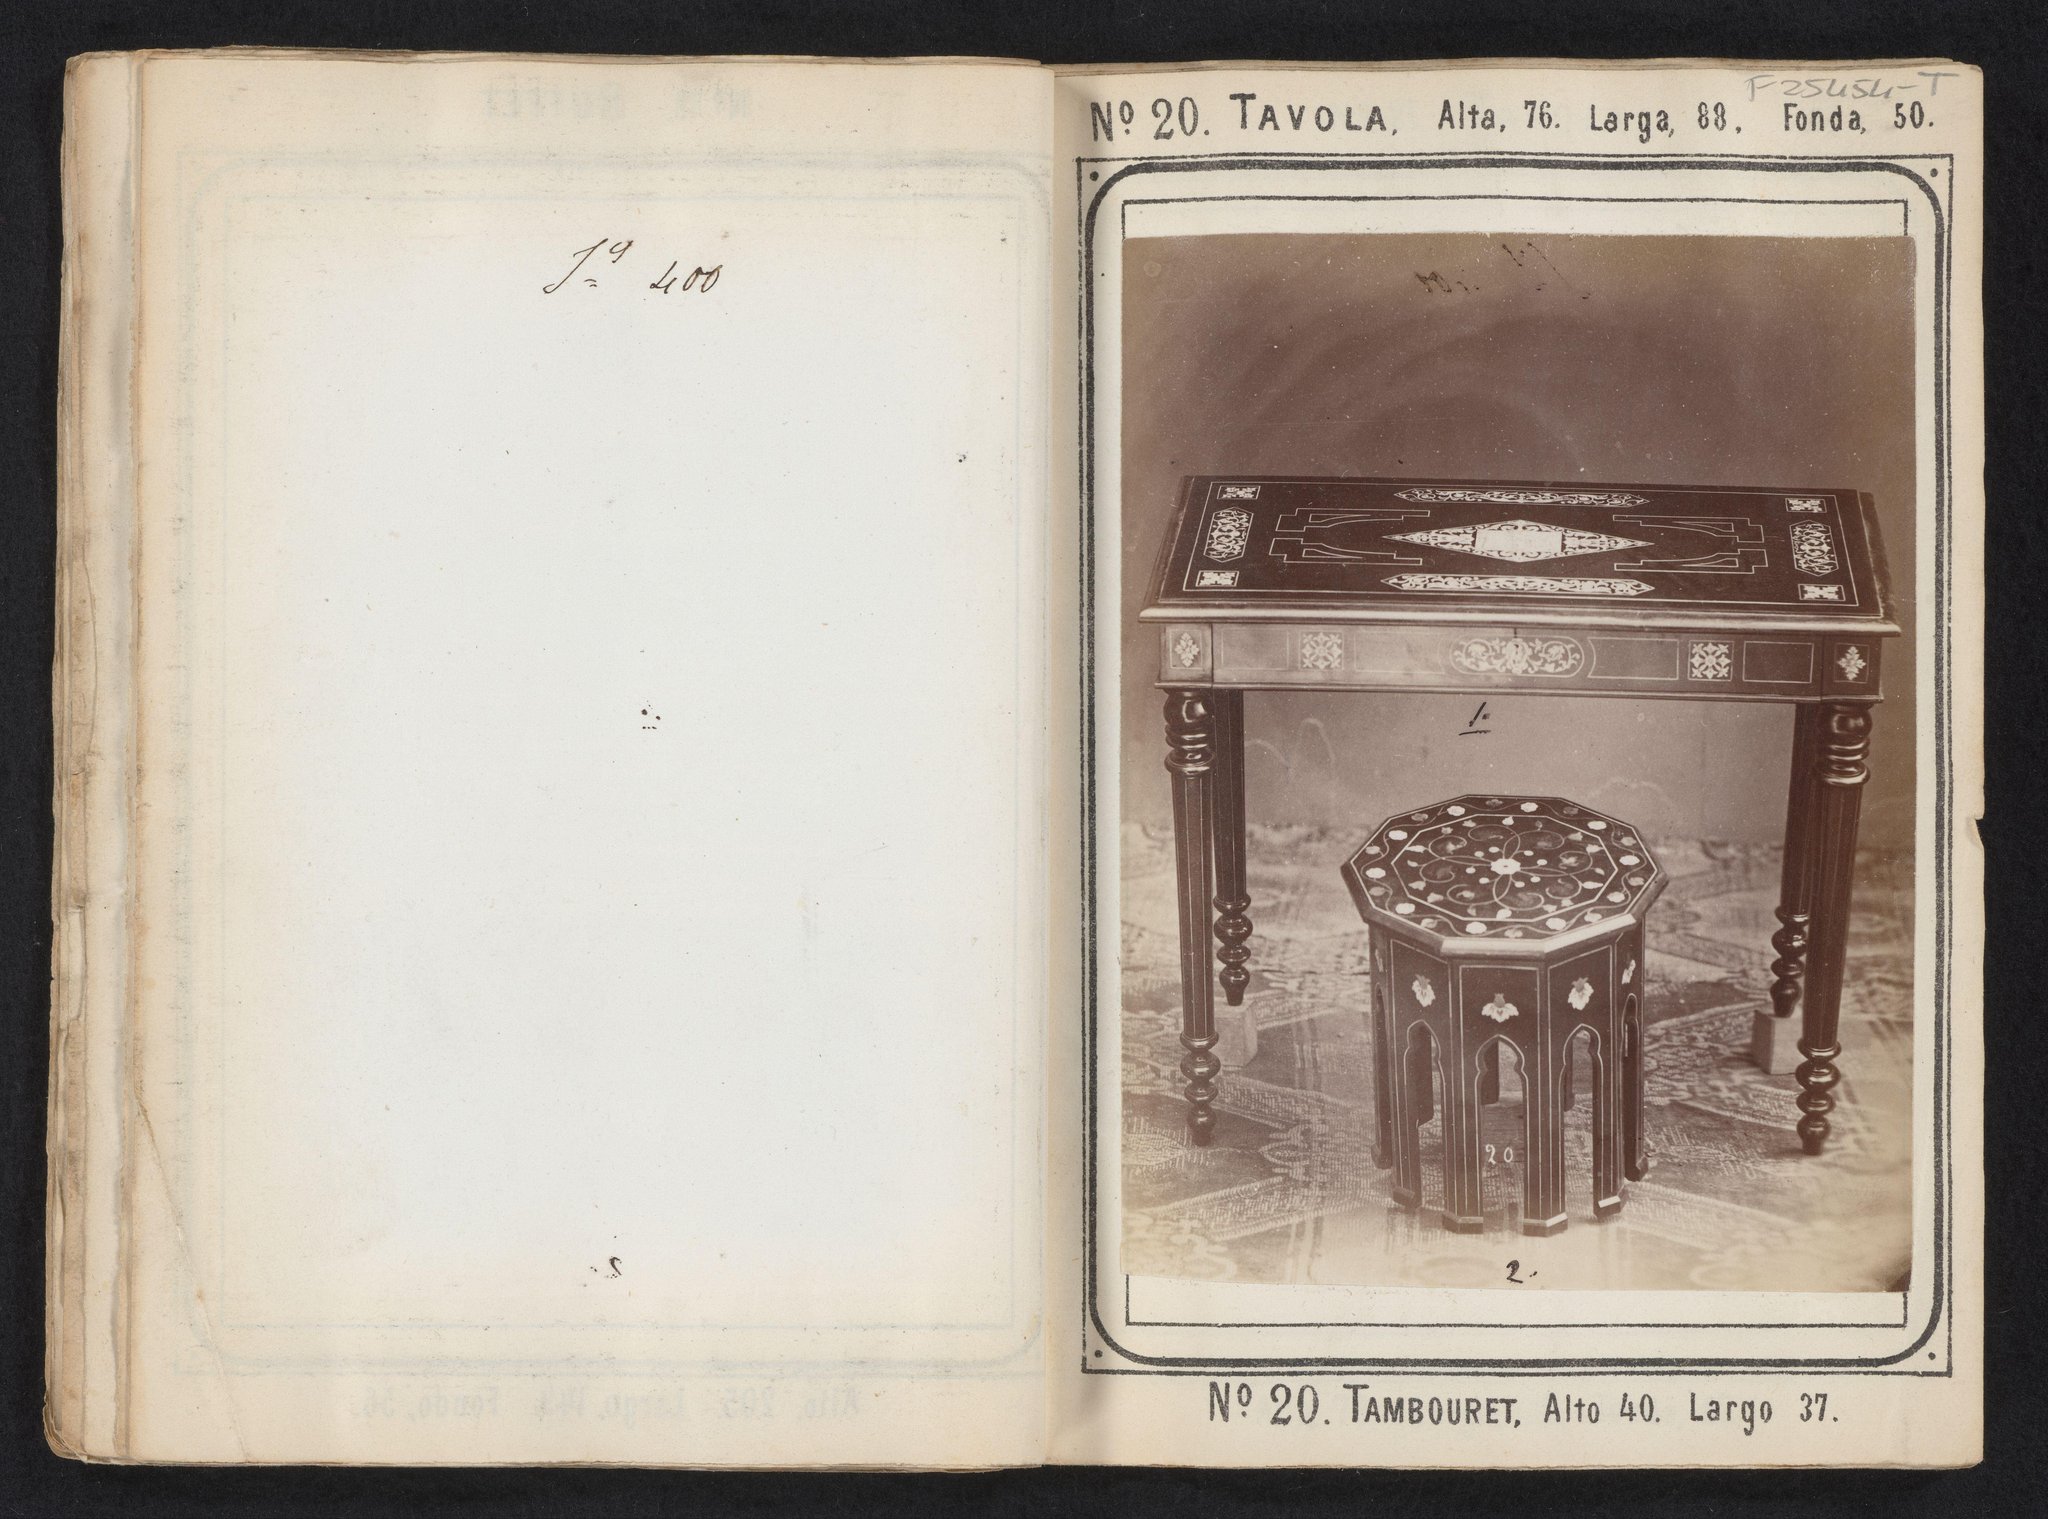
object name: photograph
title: Tafel en kruk met inlegwerk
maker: Anonymous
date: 1878-1885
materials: paper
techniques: albumen print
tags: table, stool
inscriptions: number: ‘1./ 2.’, inscription: ‘Alta, 76. Larga, 88. Fonda, 50./ Alto 40. Largo 37.’, inscription: ‘No 1. Ies. 180/ " 2 " 45.’